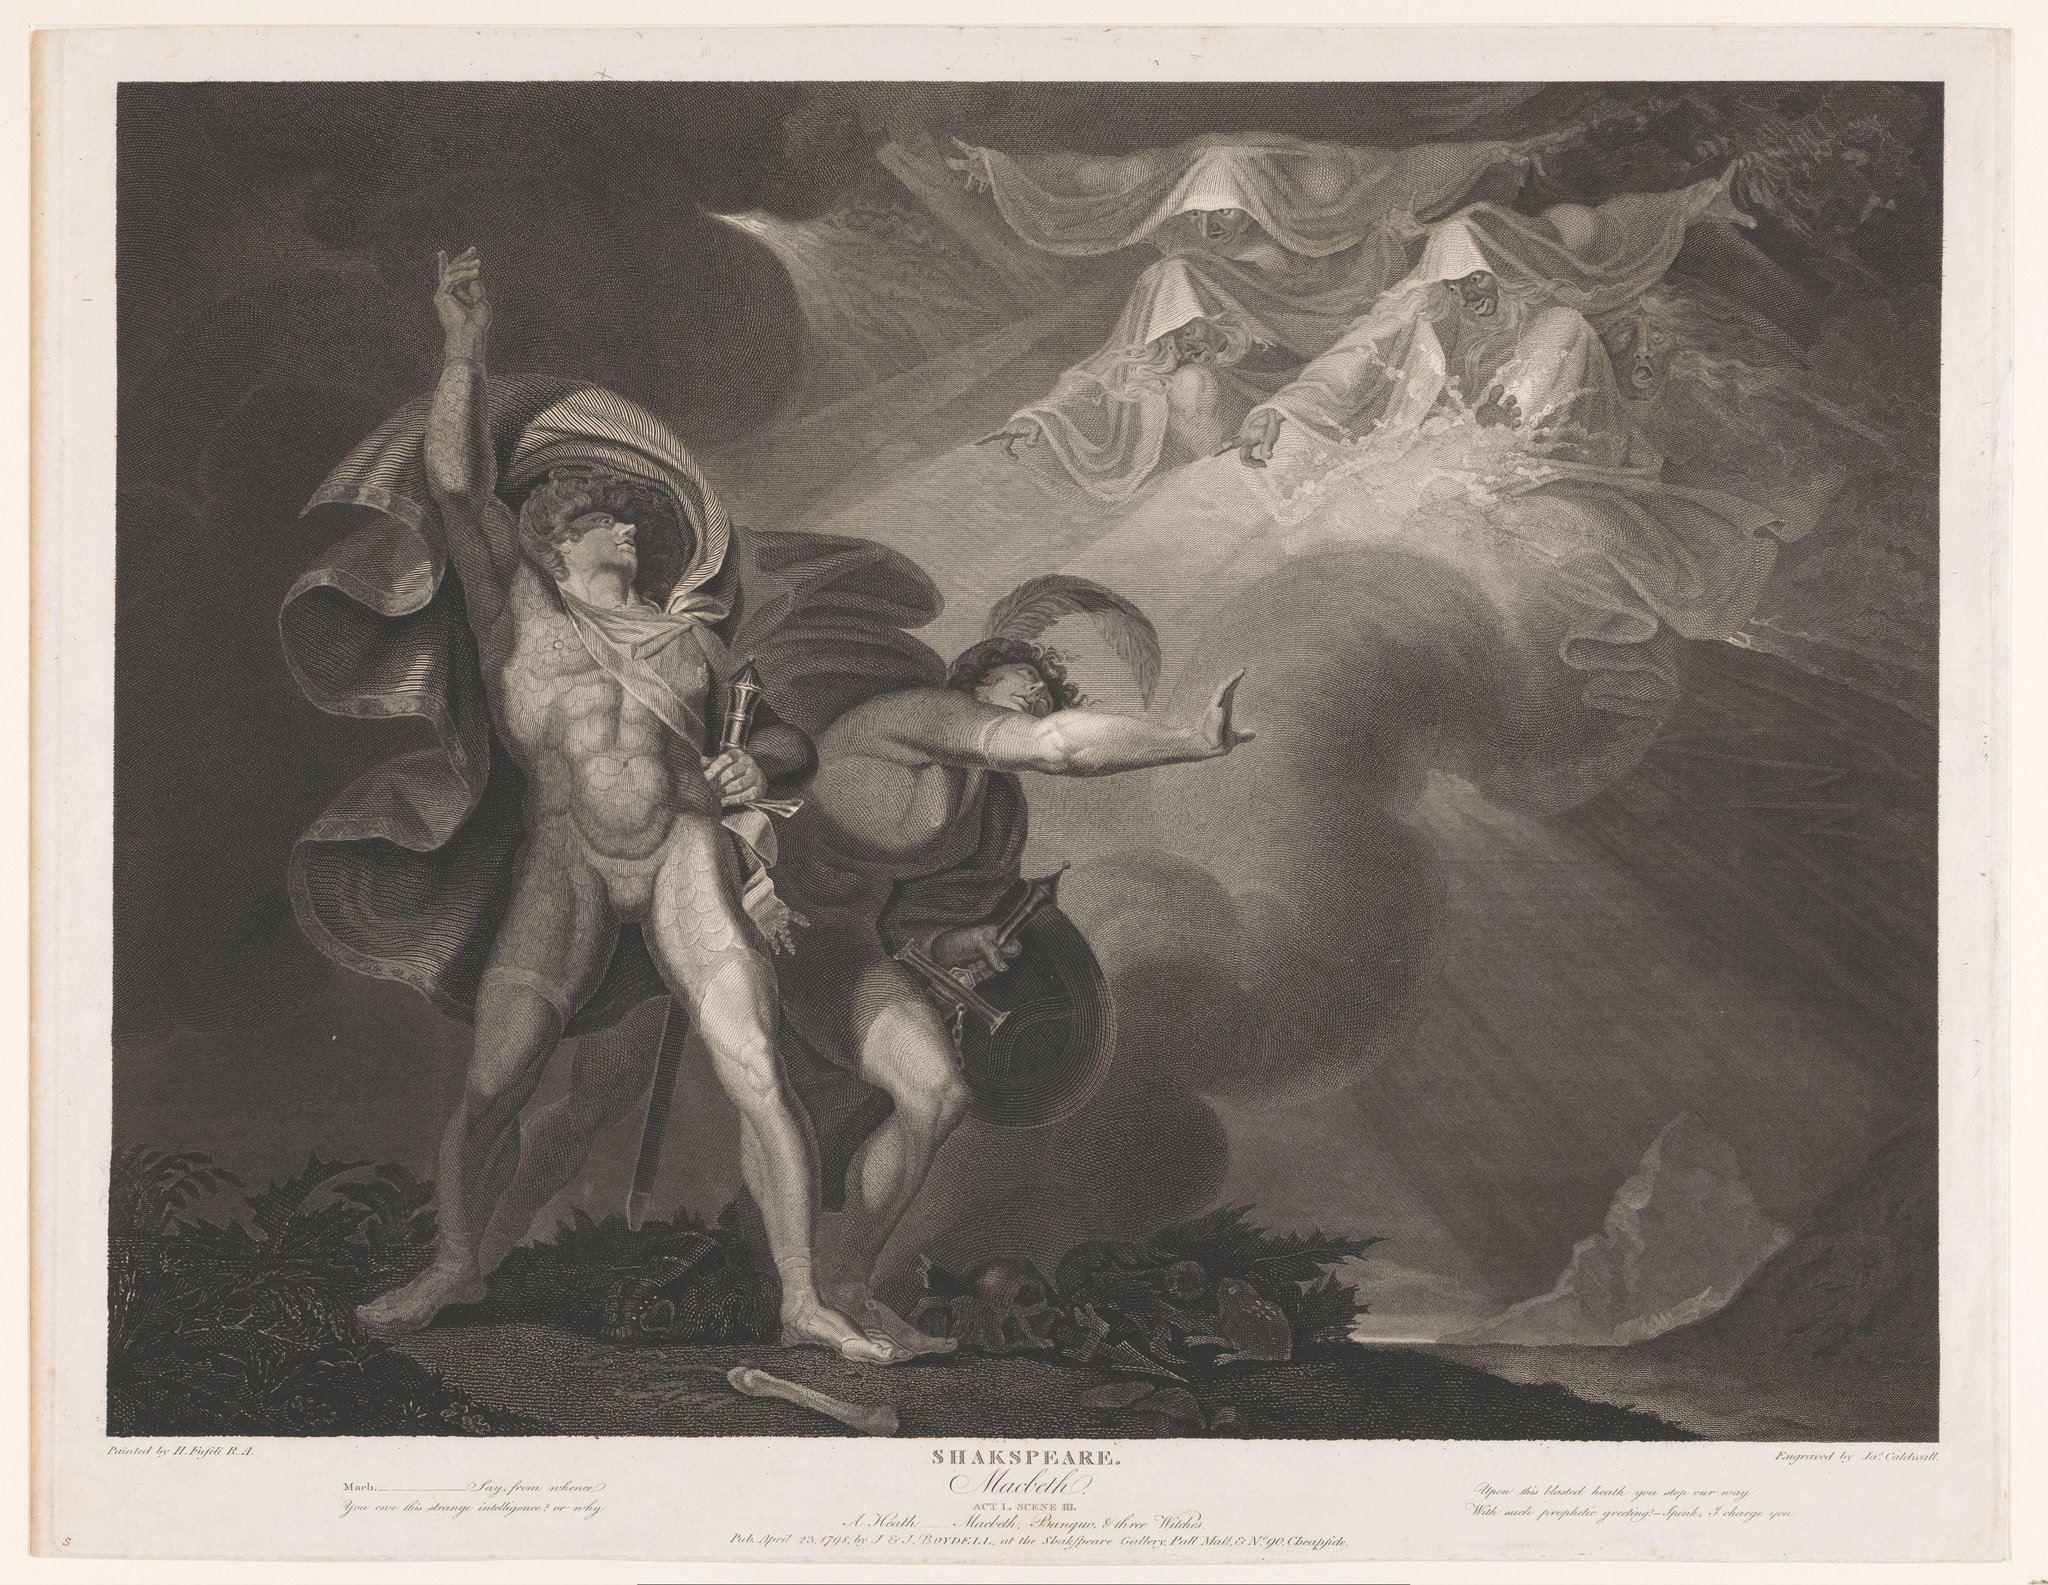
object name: print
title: Drie heksen verschijnen aan Macbeth and Banquo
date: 1798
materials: paper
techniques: engraving, etching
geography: london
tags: groups of witches, (scenes from) specific works of literature (with author, title), macbeth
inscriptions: watermark, collector's mark: Lugt 2760, collector's mark: Lugt 2228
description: De eerste ontmoeting van Macbeth met de drie heksenzusters in het veen (Shakespeare, Macbeth akte 1, scène 3). Aangezet door hun voorspellingen zal Macbeth zijn ambities vrij baan geven. De schedels en botten aan zijn voeten wijzen vooruit naar zijn gruwelijke toekomst.